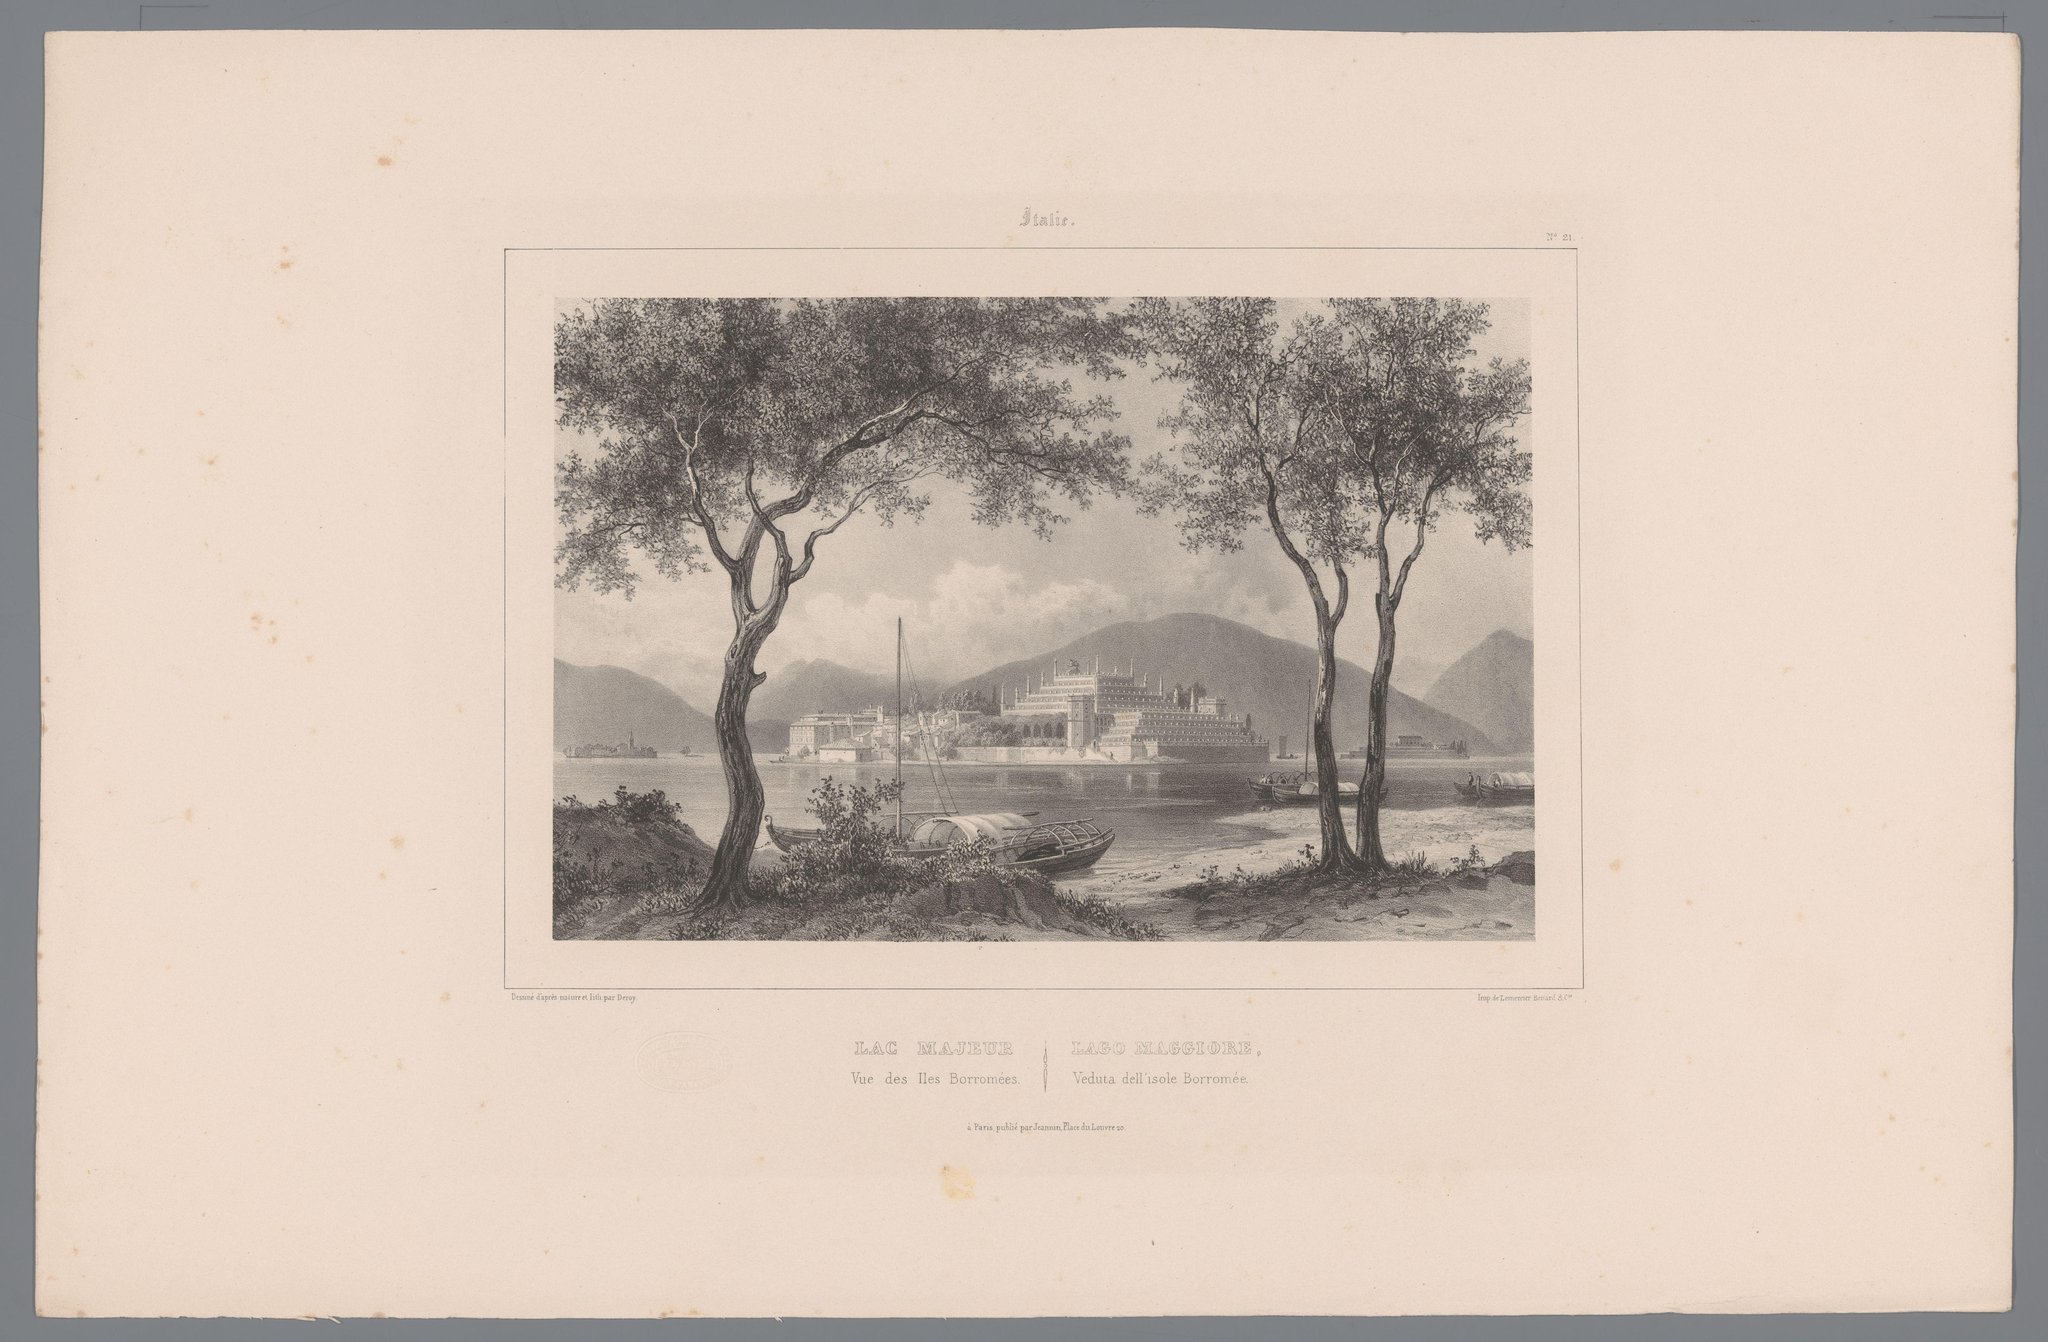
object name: print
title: Zicht op de Borromeïsche Eilanden in het Lago Maggiore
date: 1838-1841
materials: paper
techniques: lithograph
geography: paris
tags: island, mountains (+ landscape with figures, staffage), lake (+ landscape with figures, staffage), boat propelled by man or animal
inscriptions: check stamp: Lugt 1397c, collector's mark: Lugt 2228a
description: Prent maakt deel uit van een omslag met zes prenten.